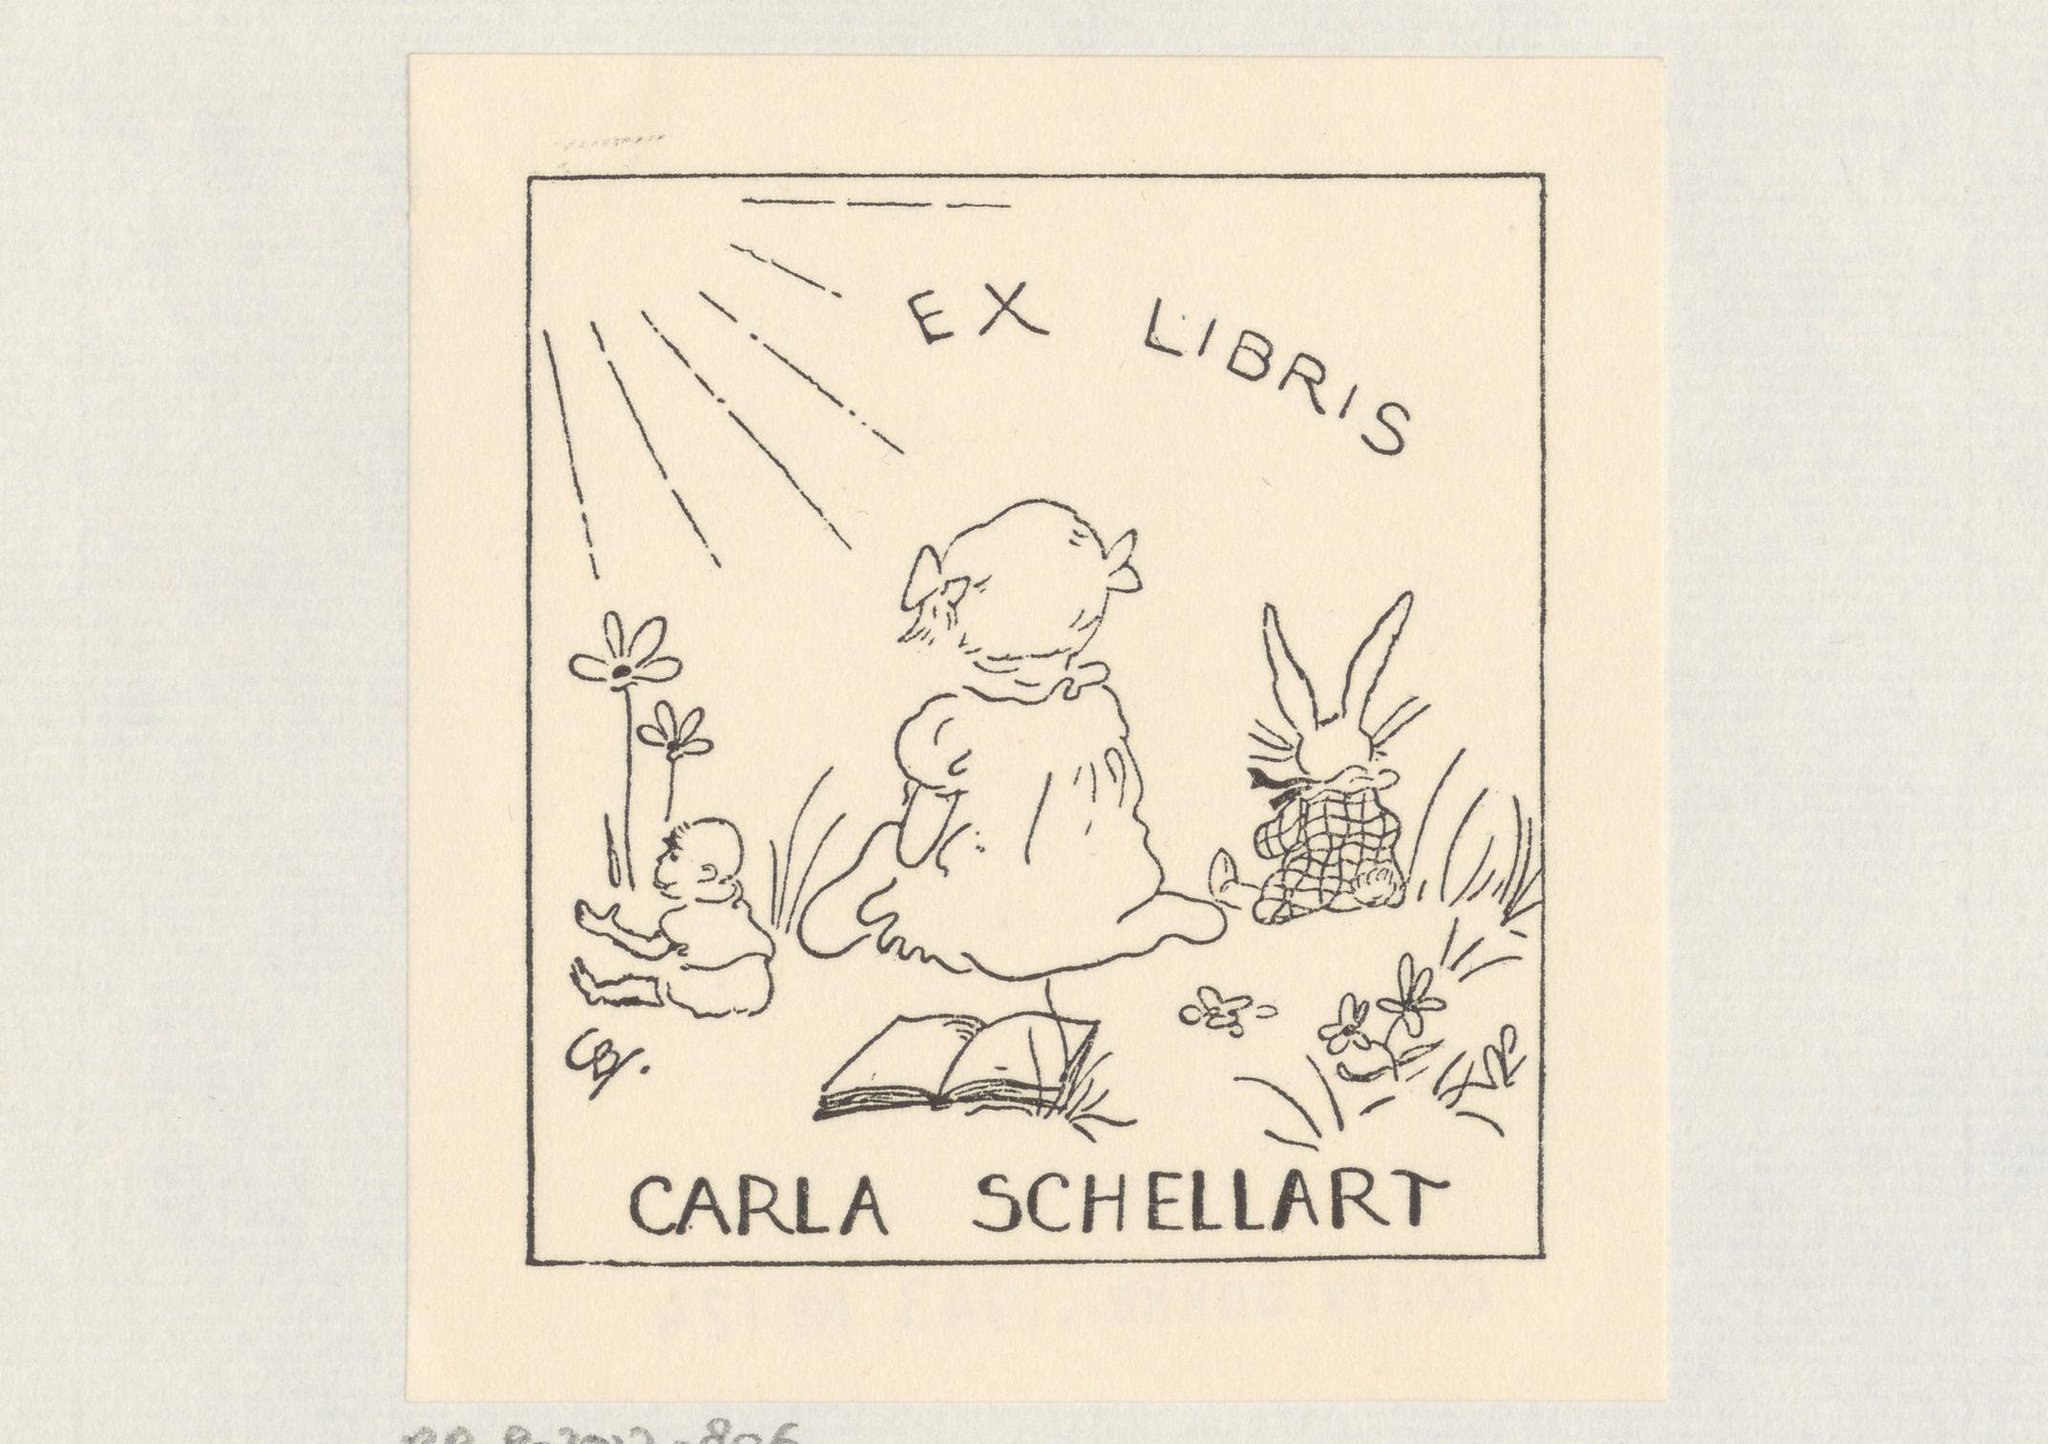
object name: bookplate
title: Ex libris van Carla Schellart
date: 1943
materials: paper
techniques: printing block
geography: netherlands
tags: book, toddler (female), (playing with) dolls, toy animals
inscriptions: workshop stamp: ‘Corry Bakker.1943 No 124’